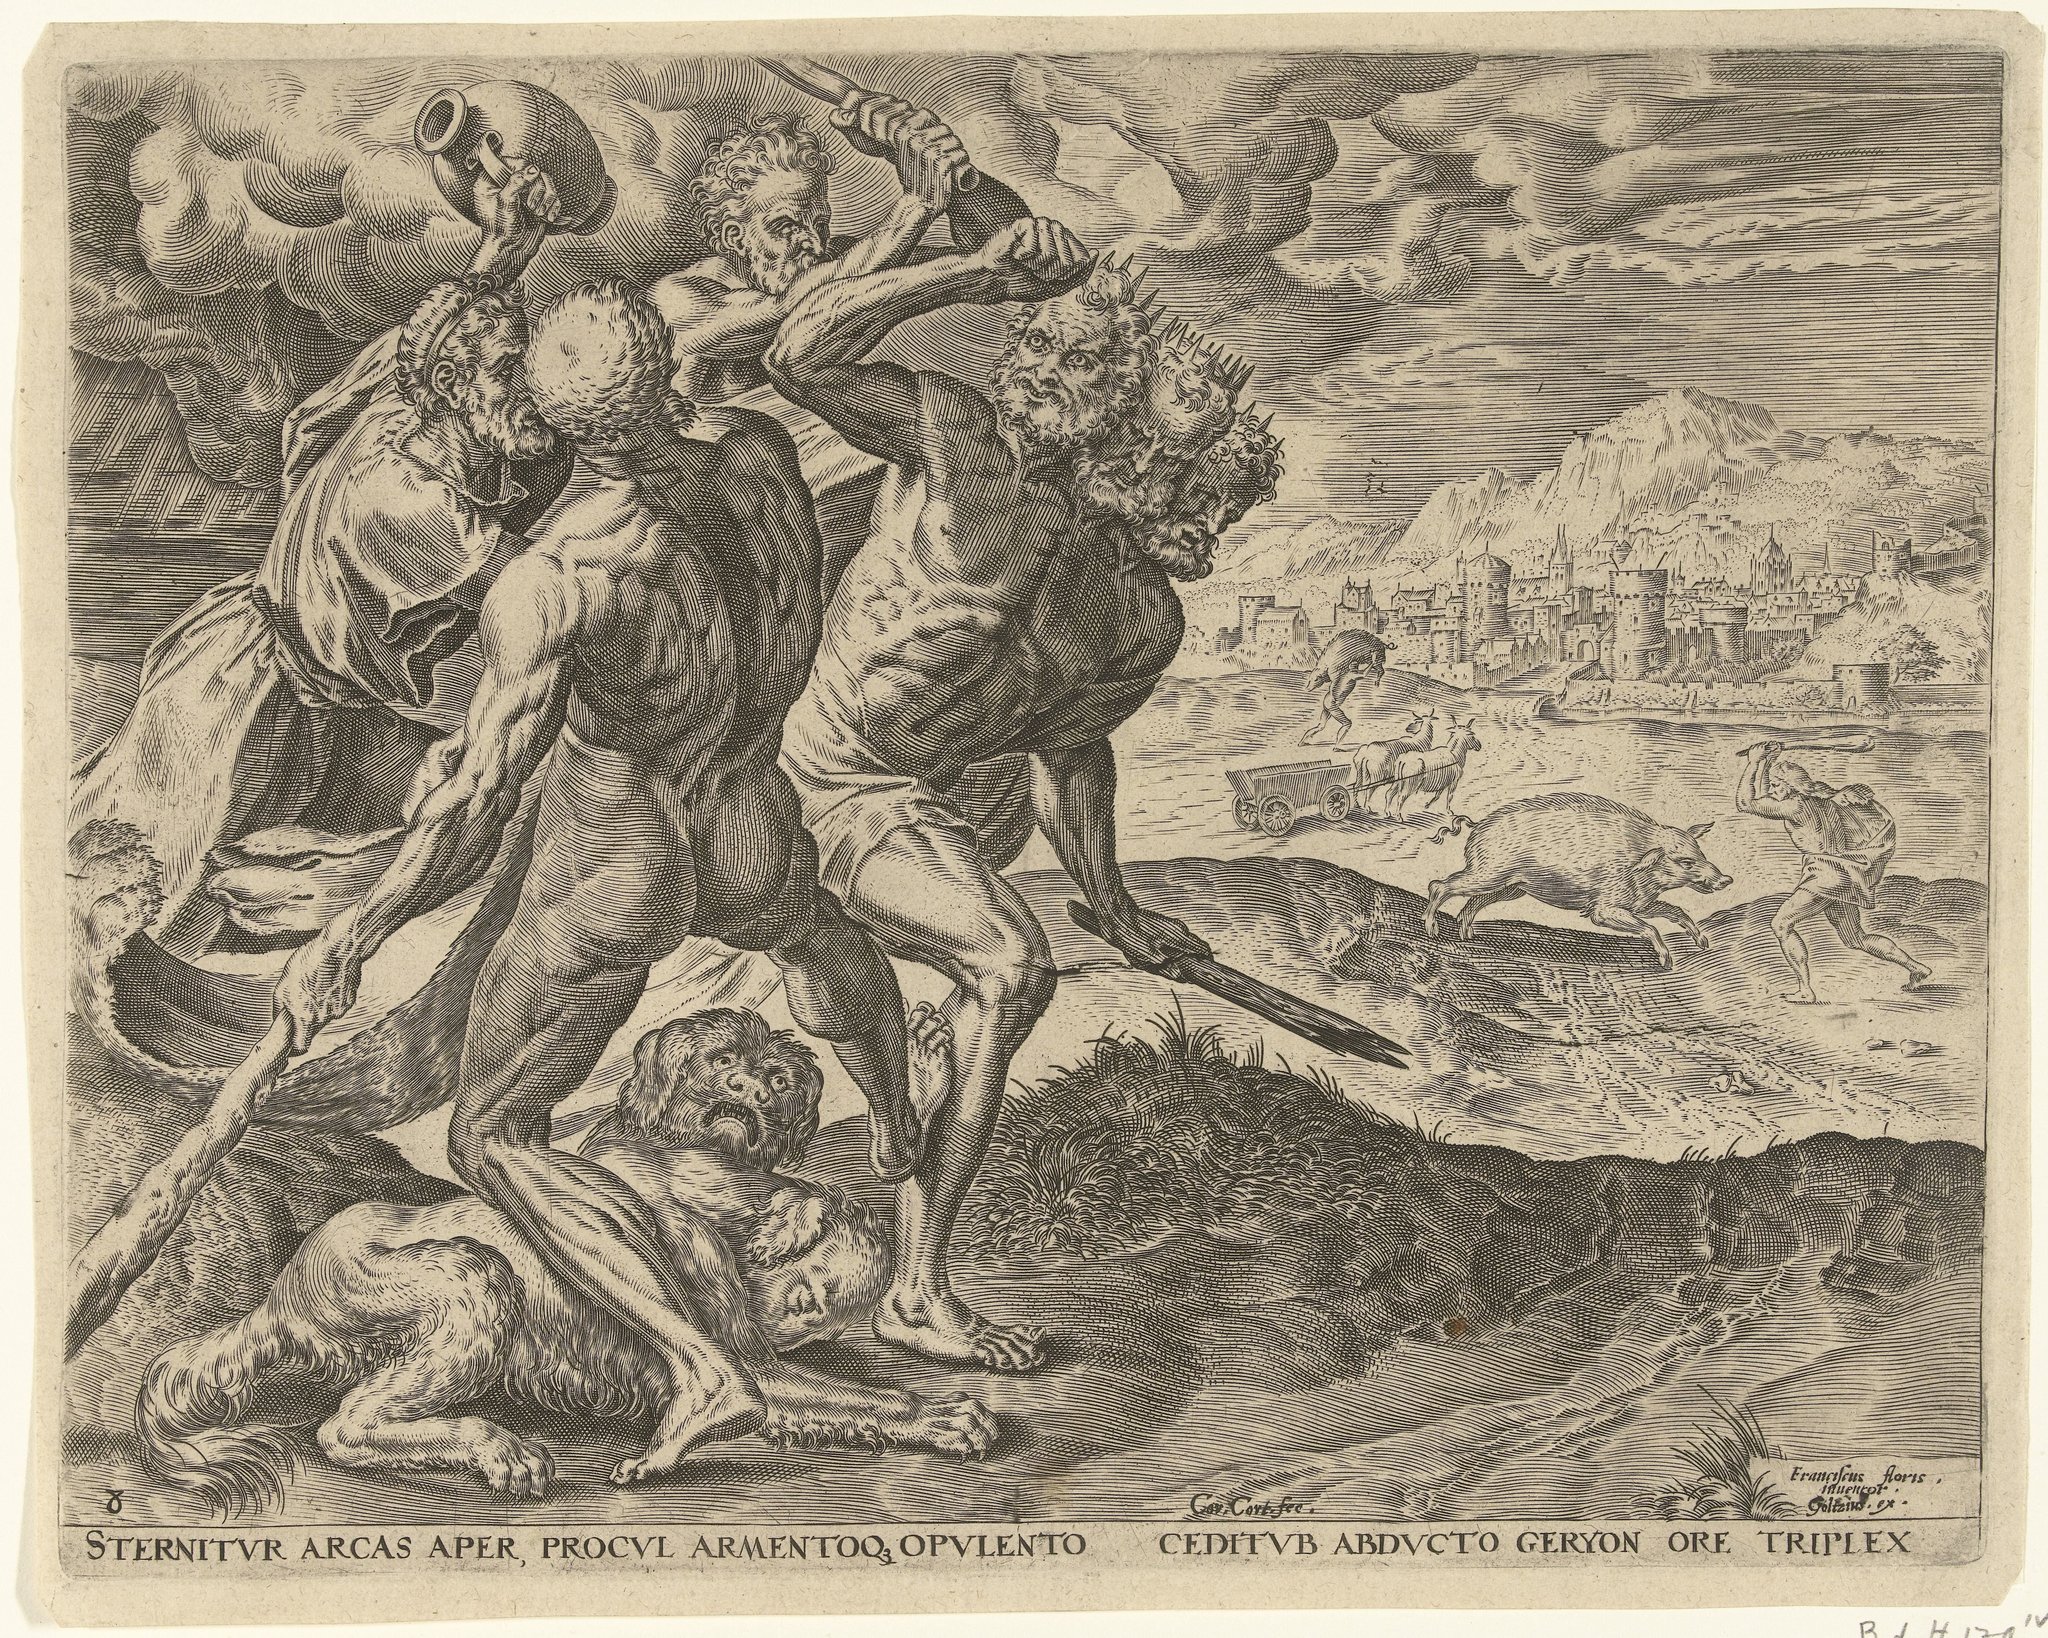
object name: print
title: Werken van Hercules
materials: paper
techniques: engraving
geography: antwerp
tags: (4) the erymanthian boar is captured by hercules, hercules kills geryon, the monster with three heads and three bodies, after having slain the herdsman eurytion, and orthrus, the two-headed watch-dog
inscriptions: collector's mark: Lugt 2228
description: Hercules verslaat de driekoppige reus Geryon en zijn tweekoppige hond. Op de achtergrond is te zien hoe Hercules het zwijn van Erymanthus vangt en naar de stad brengt.